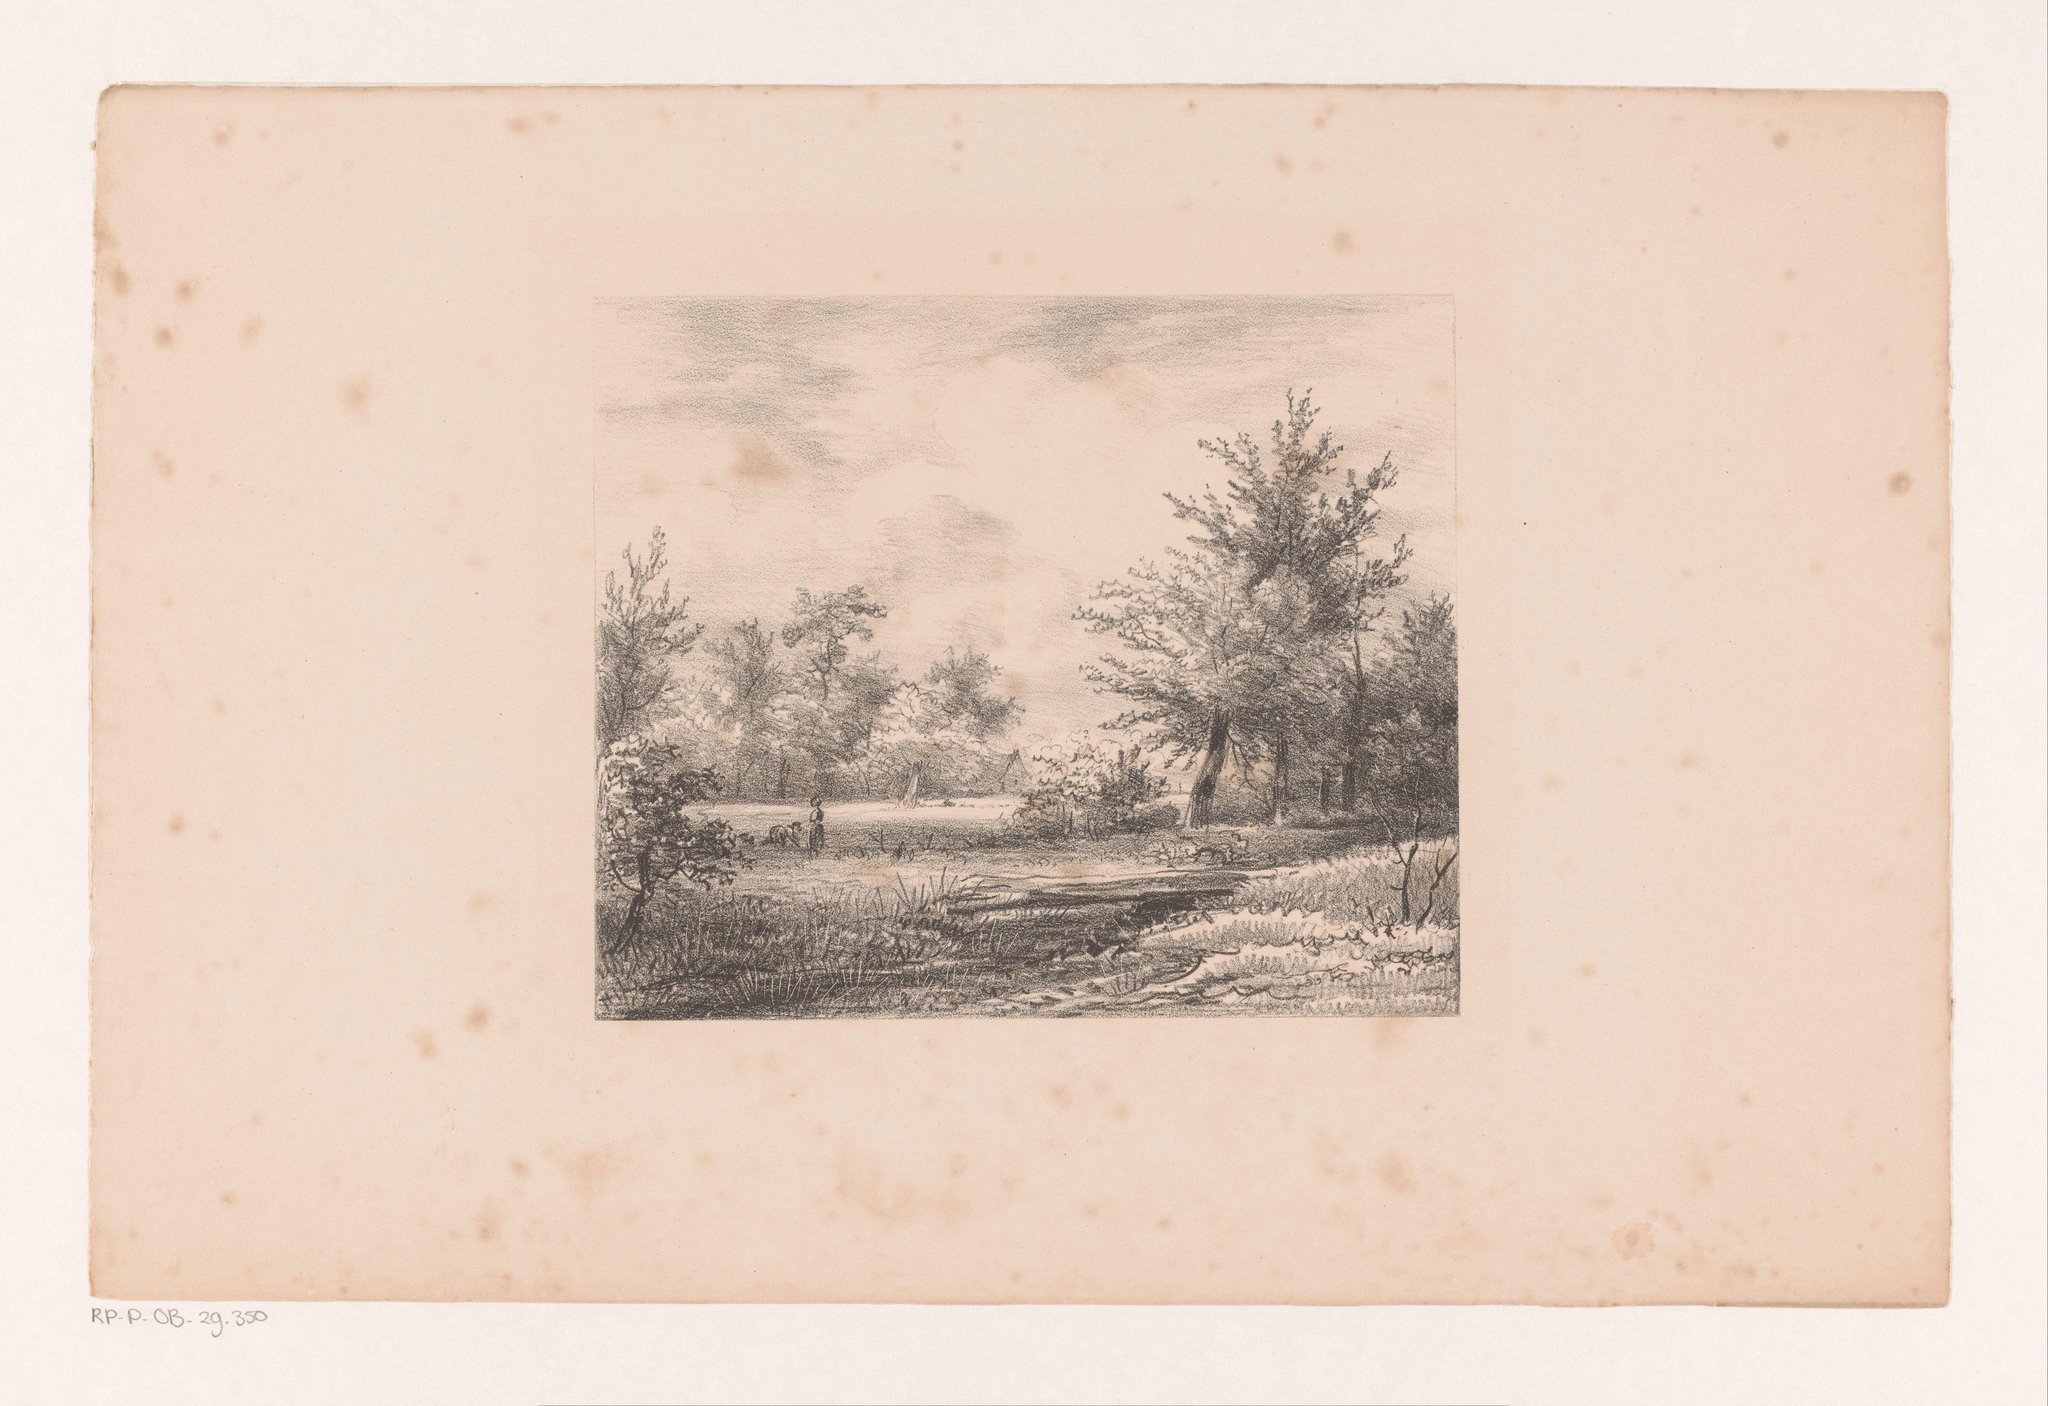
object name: print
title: Twee figuren in een landschap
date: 1809-1861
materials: paper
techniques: lithograph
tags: landscapes, farm or solitary house in landscape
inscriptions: collector's mark: Lugt 2228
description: Twee figuren in een landschap met bomen en in de achtergrond een boerderij.